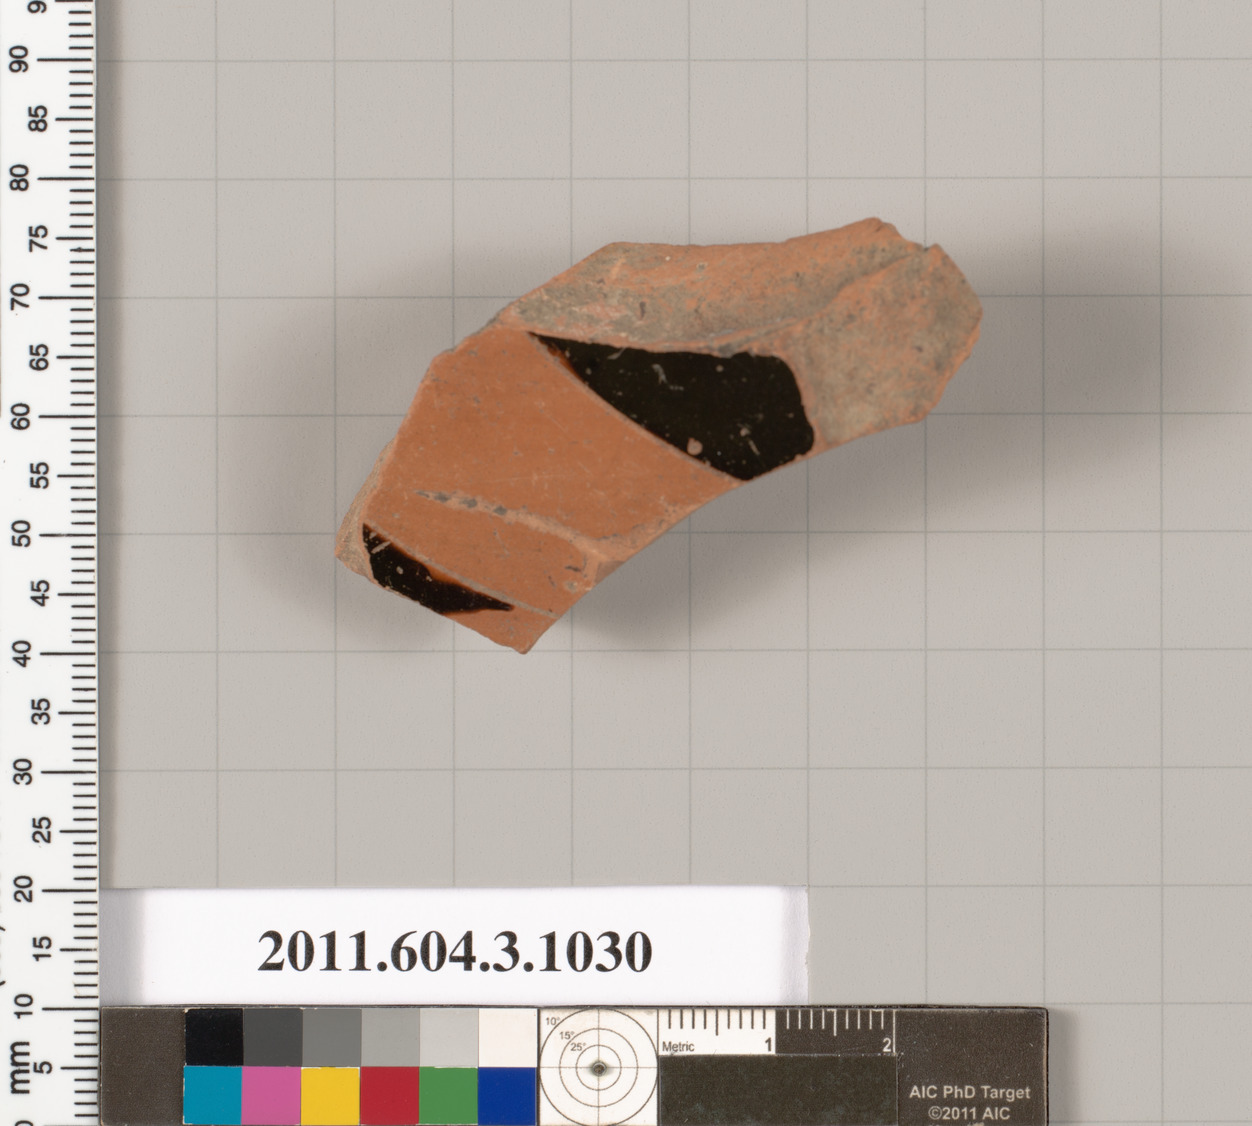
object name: undetermined shape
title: Terracotta fragment of an undetermined shape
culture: greek, attic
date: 600-401 BCE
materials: terracotta